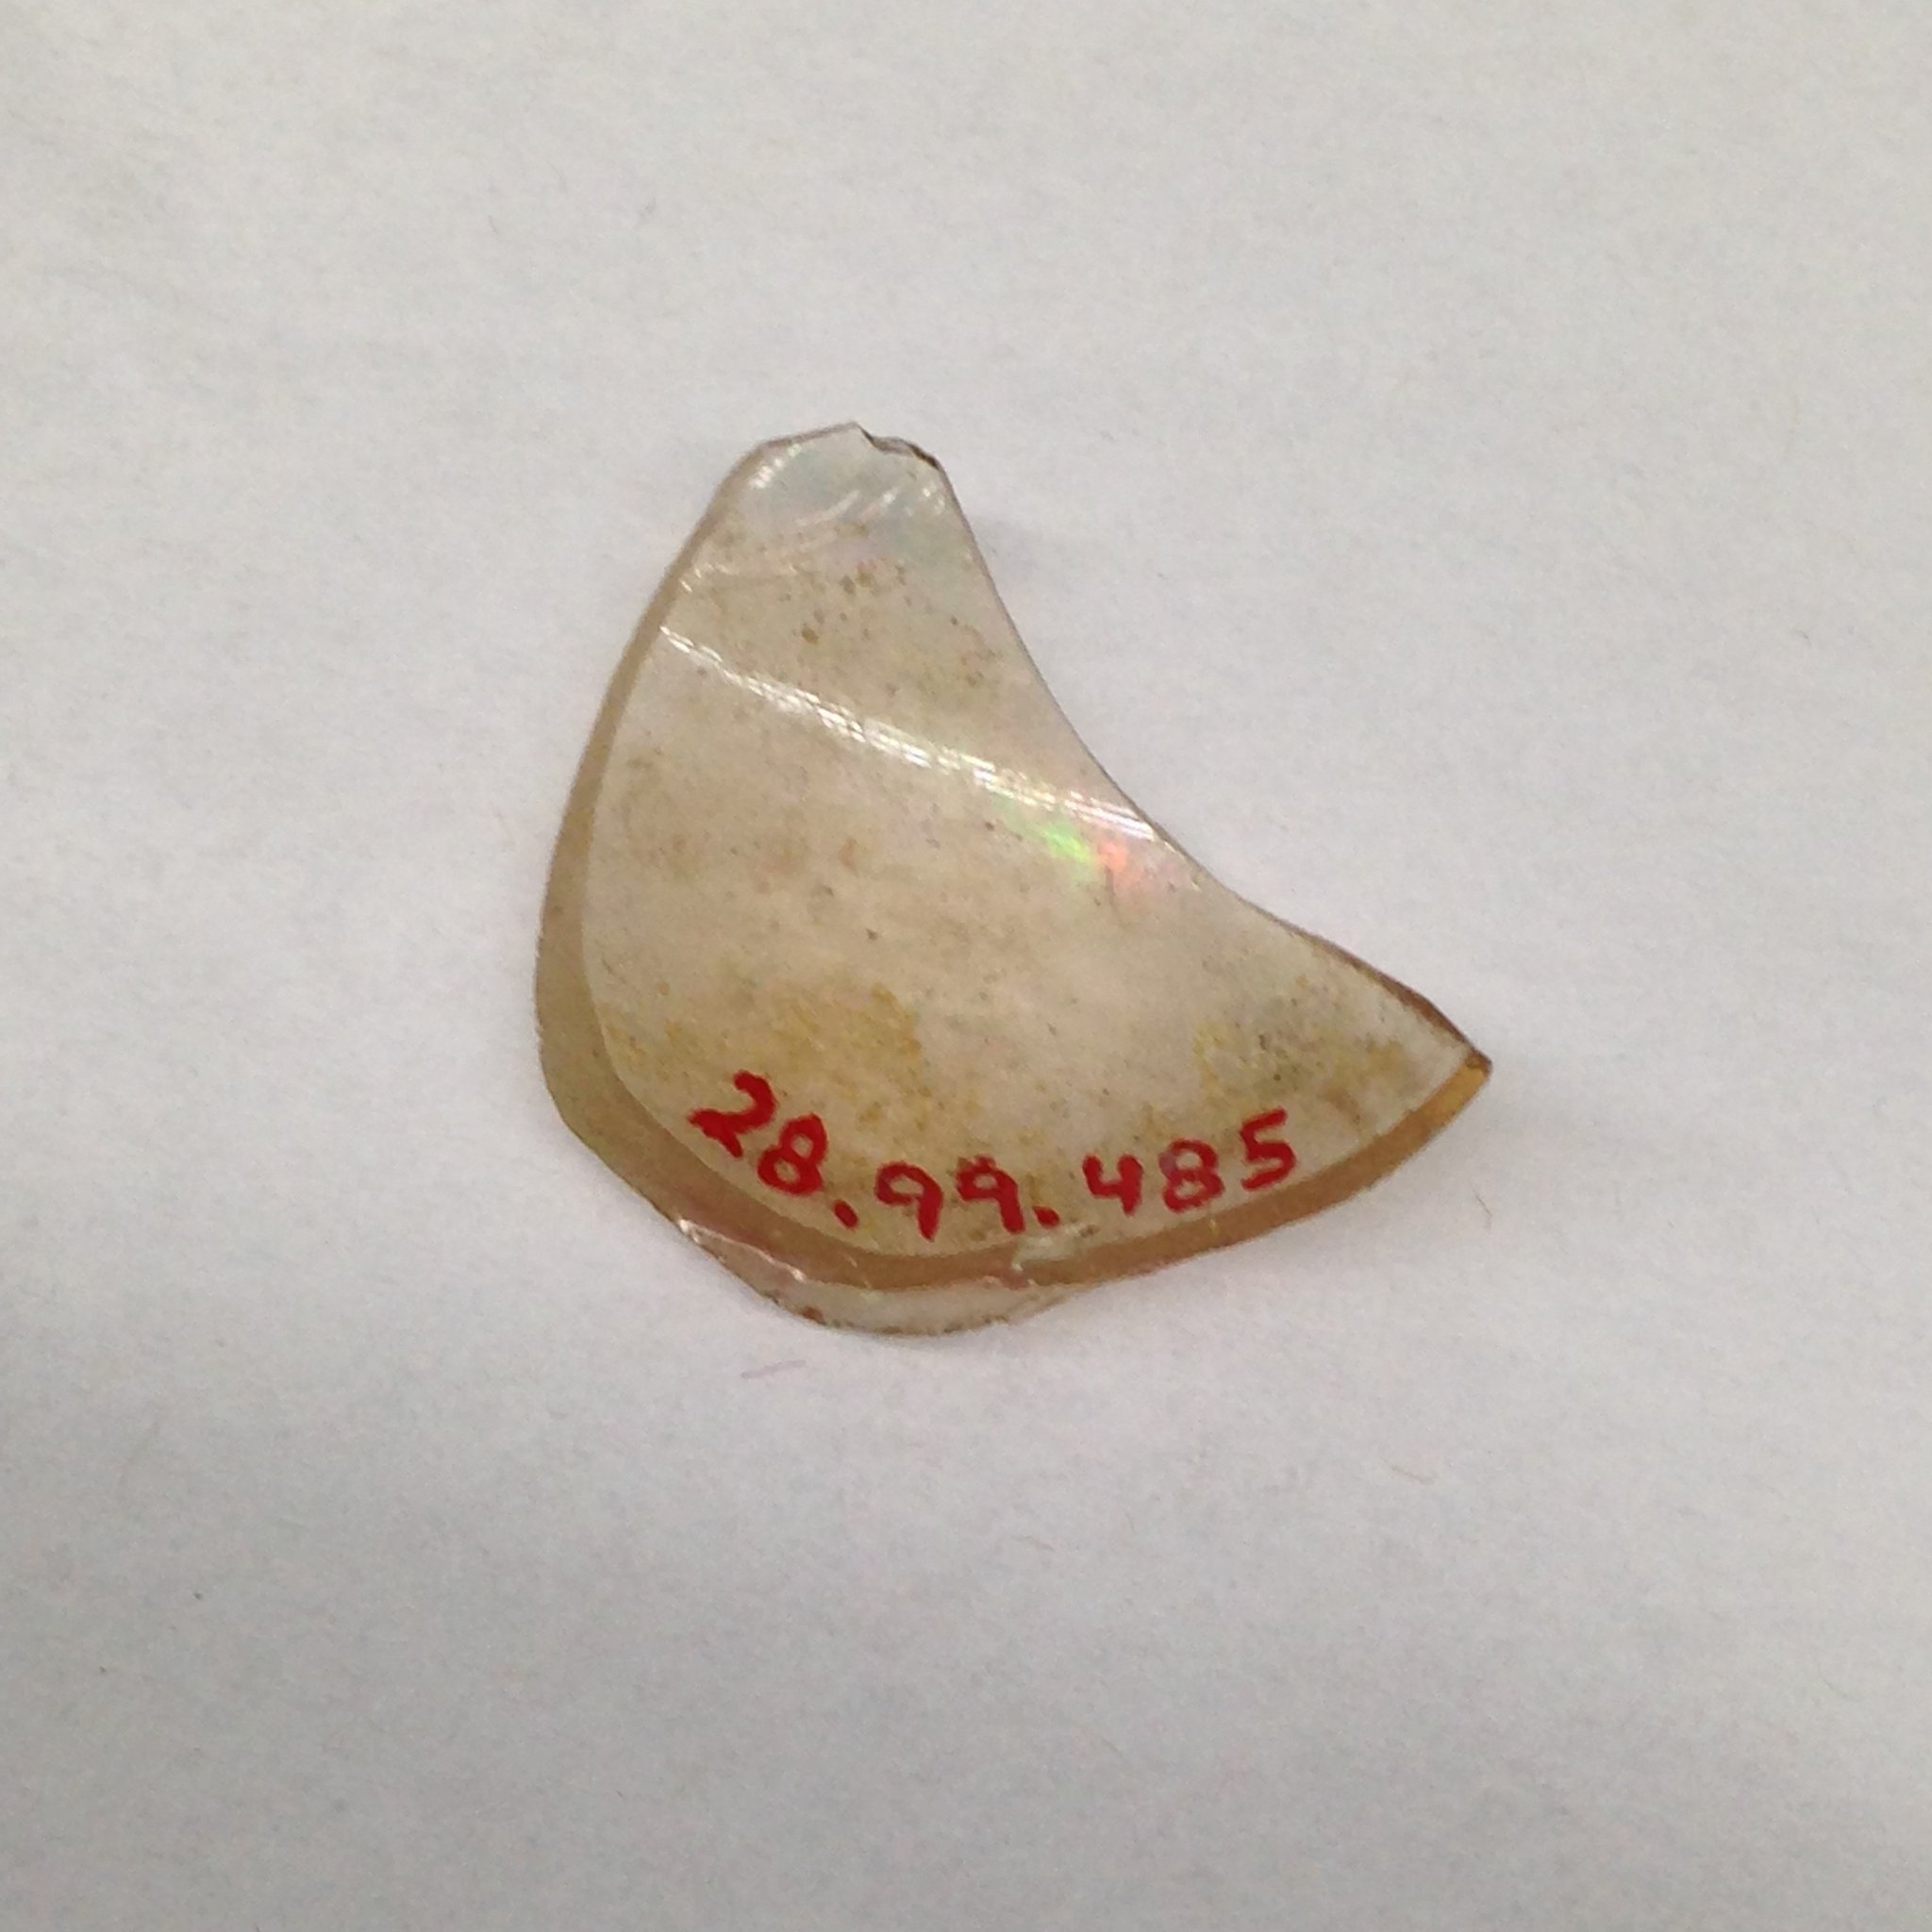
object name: fragment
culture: european or middle eastern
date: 1150-1250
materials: ceramic, glass